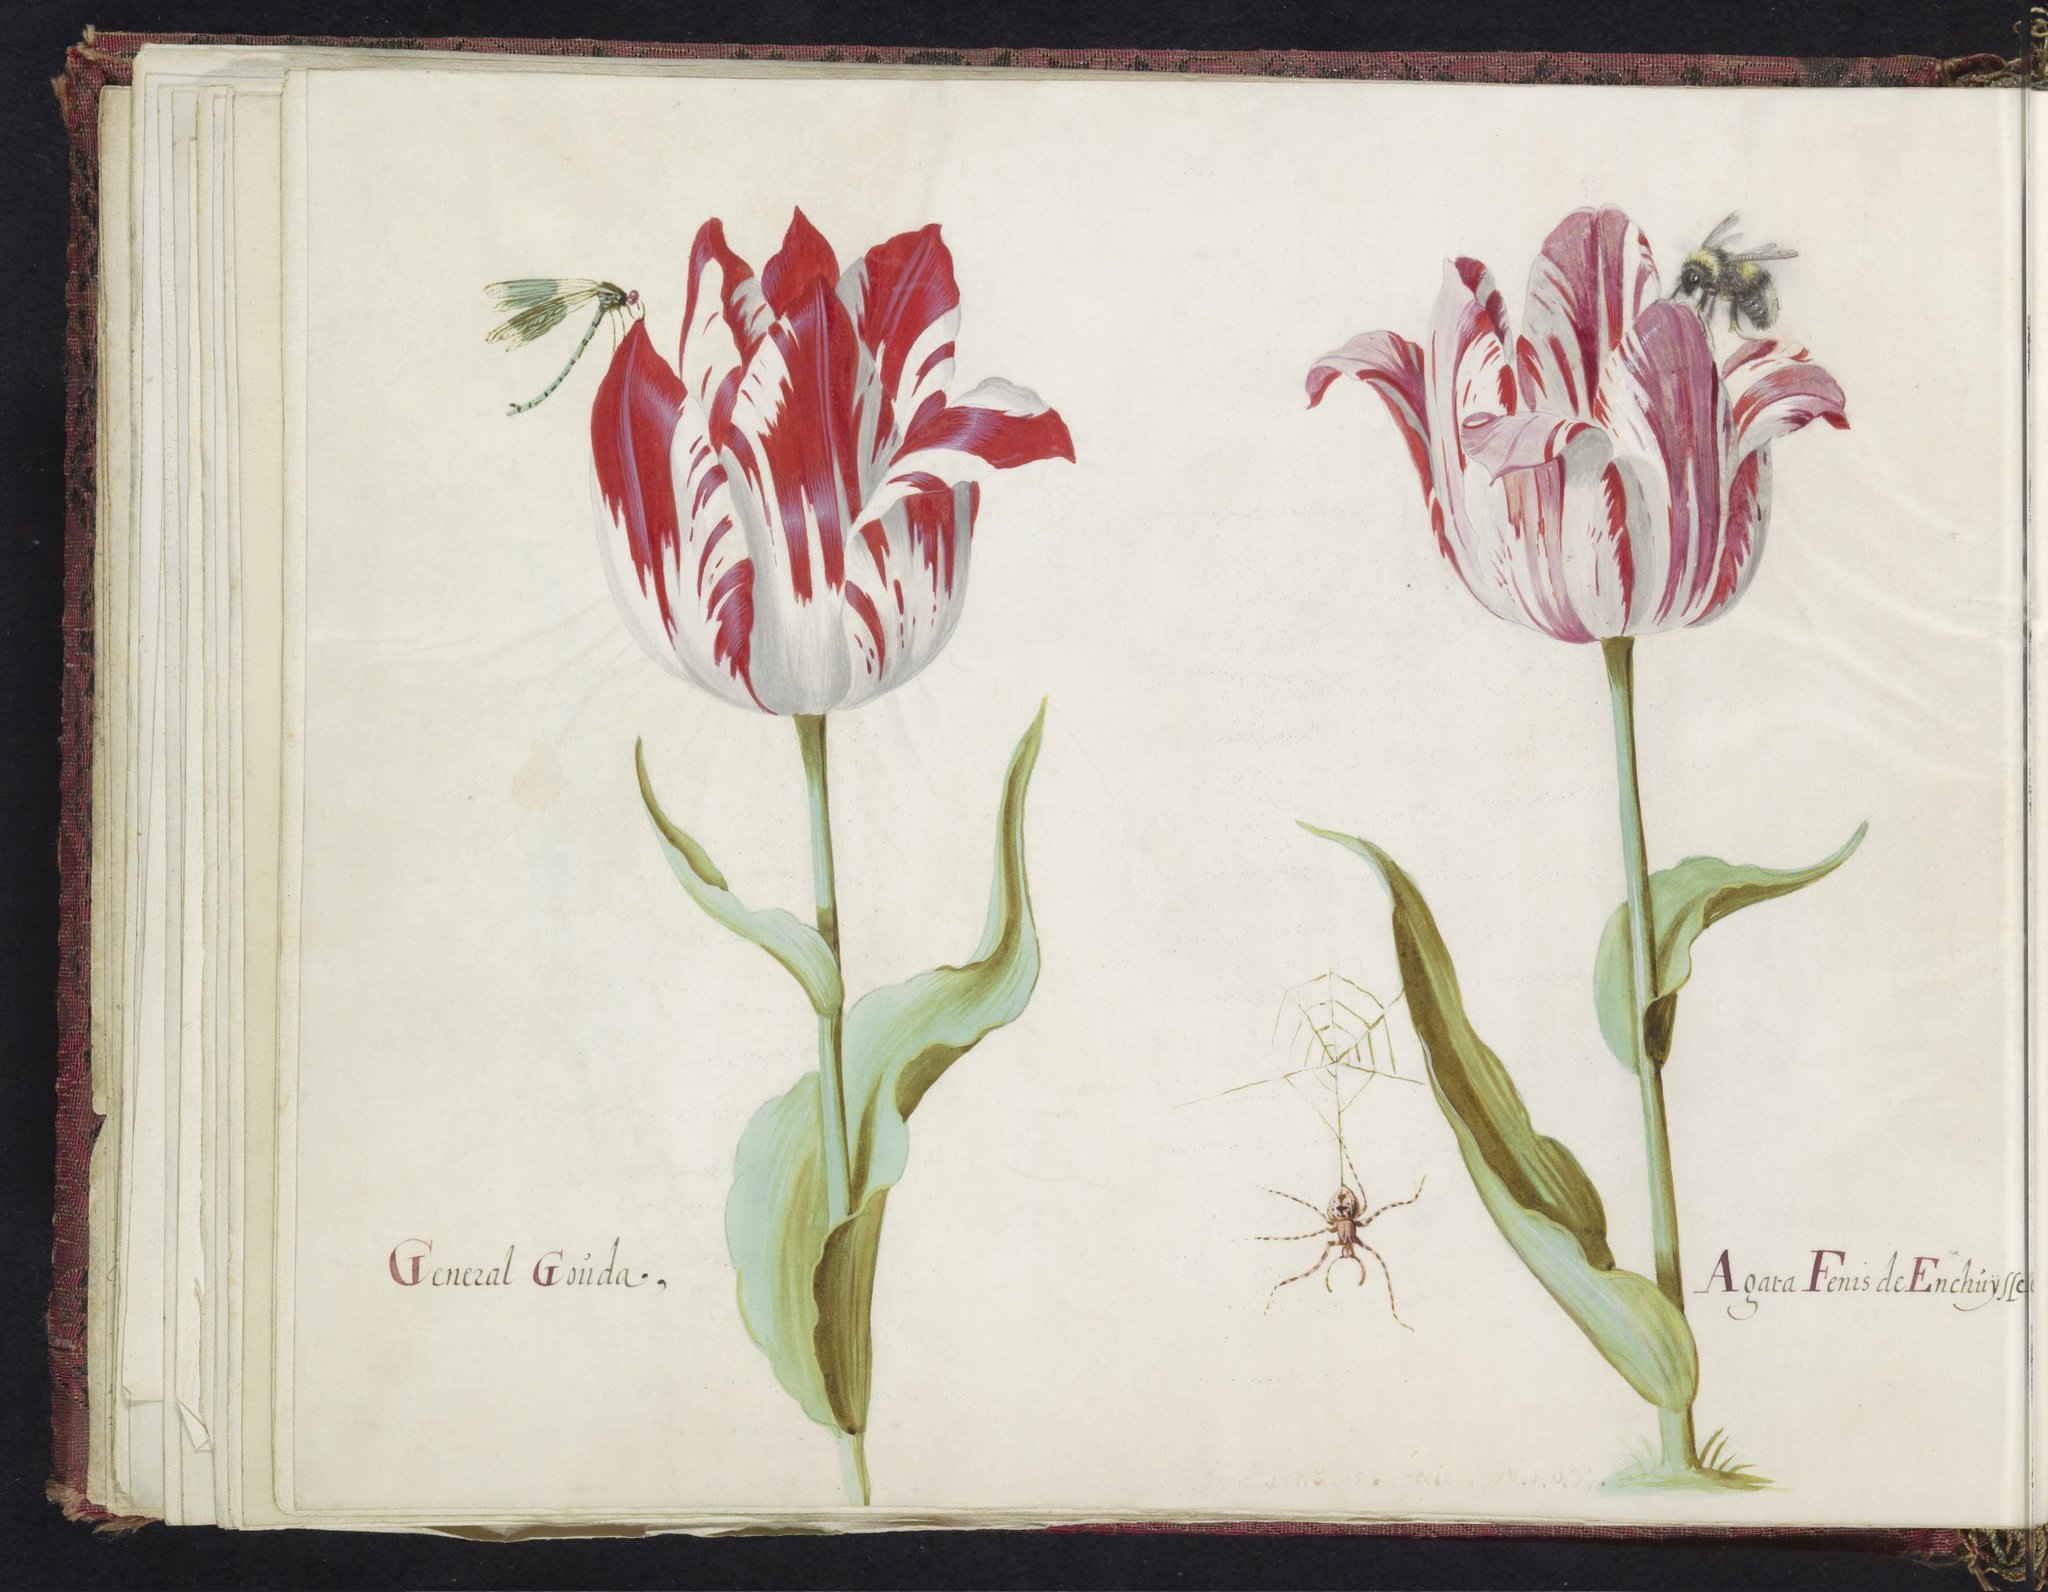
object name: album leaf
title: Twee tulpen met libelle, spin en hommel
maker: jacob marrel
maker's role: draughtsman, painter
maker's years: 1614-1681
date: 1637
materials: paint, parchment, pencil, watercolor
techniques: brush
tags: insects: dragon-fly, spiders, flowers: tulip, insects: bumblebee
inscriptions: date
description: De tekening maakt deel uit van een album.